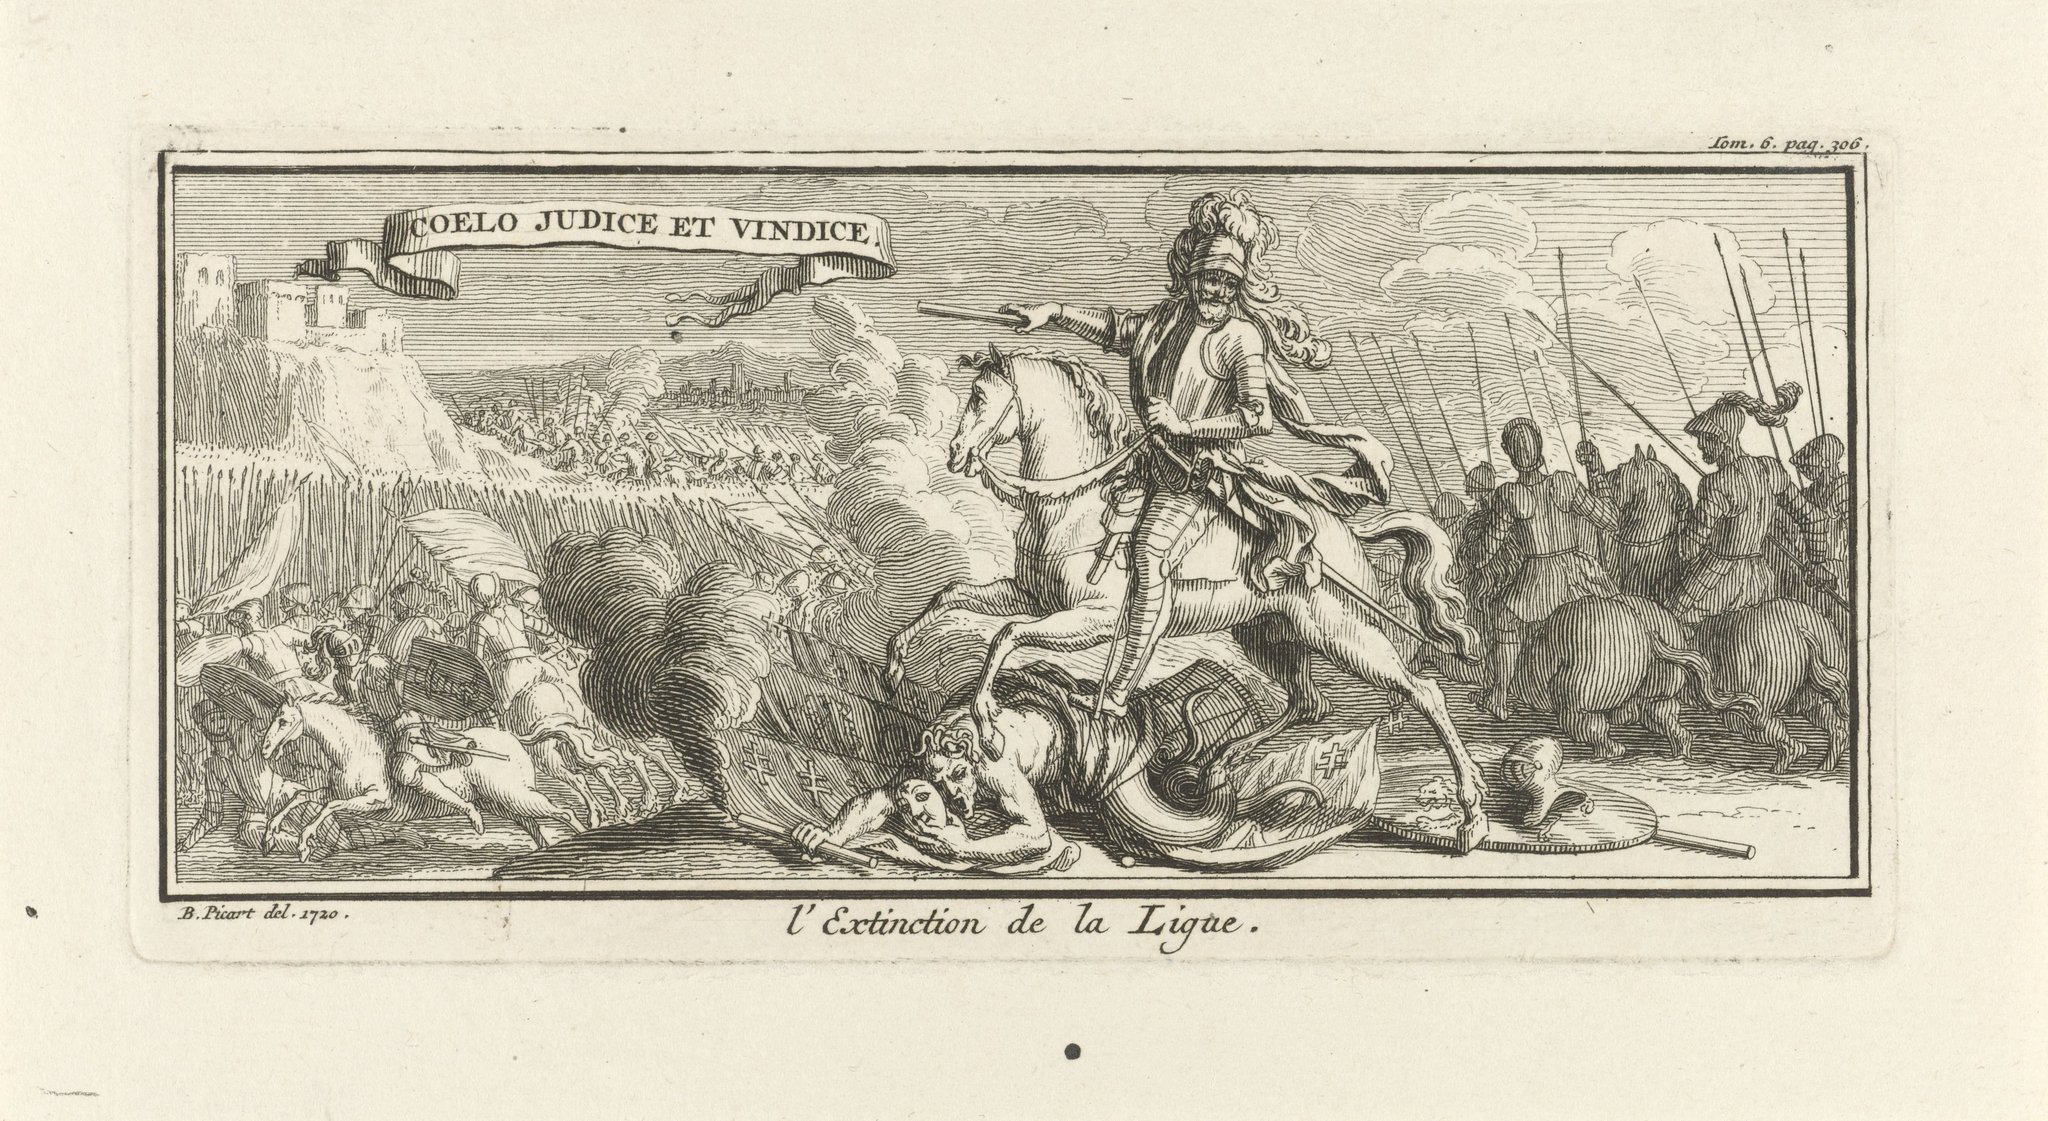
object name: book illustration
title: Opheffing van de Heilige Liga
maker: bernard picart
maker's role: draughtsman, print maker, publisher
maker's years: 1673-1733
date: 1720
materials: paper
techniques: engraving, etching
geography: amsterdam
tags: siege, knight, alliance, league, union, foedus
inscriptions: collector's mark: Lugt 2228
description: Een ruiter in harnas met commandostaf in de hand vertrapt de gepersonifieerde Heilige Liga. Op de achtergrond de belegering van een stad. Linksboven op een banderol een motto in het Latijn. Rechtsboven gemerkt: Tom. 6 pag. 306.